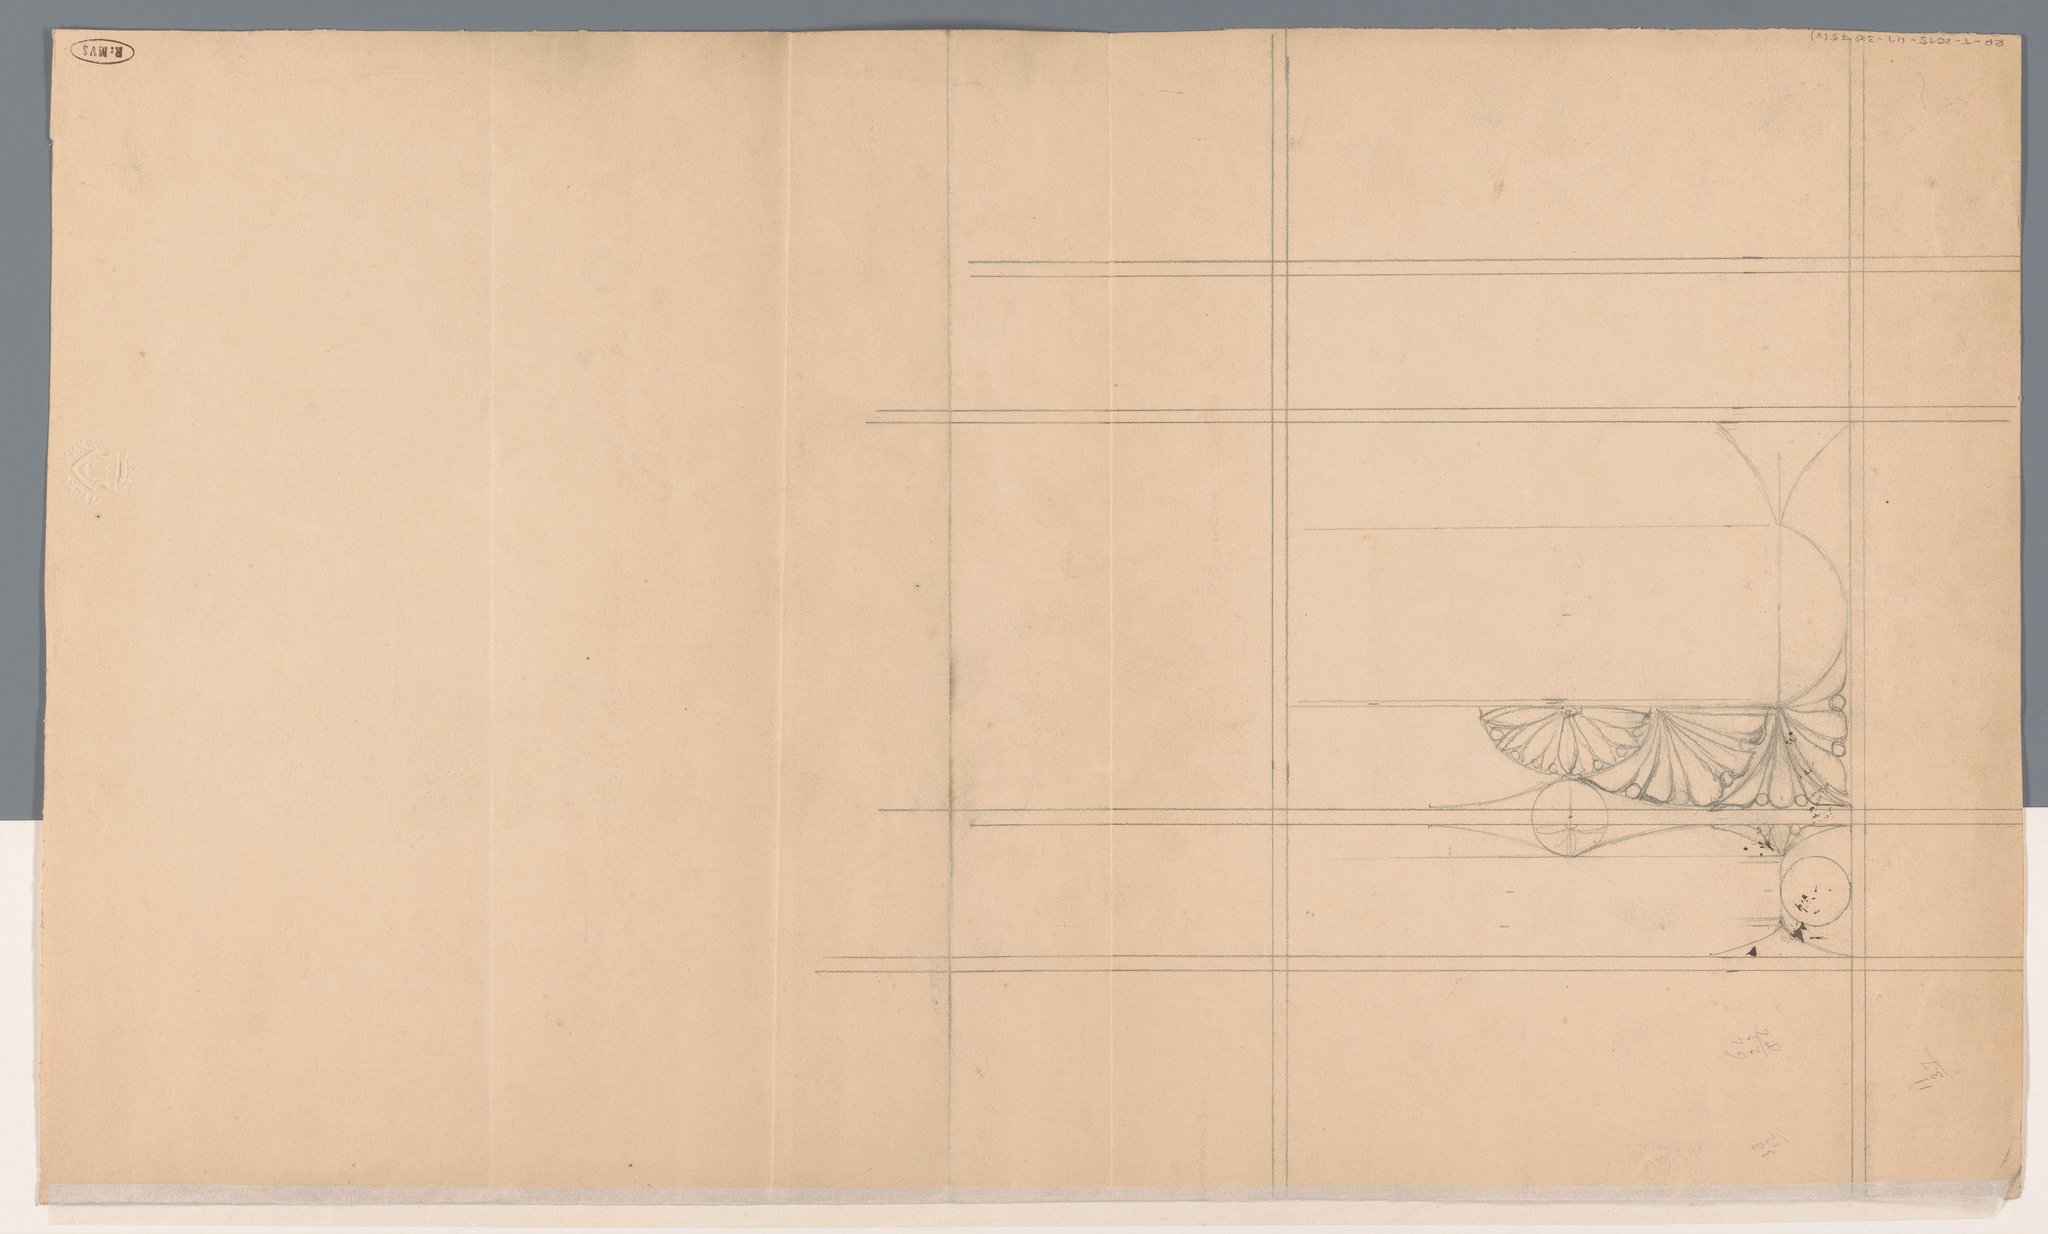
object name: drawing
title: Bandontwerp voor: Max Rooses, De teekeningen der Vlaamsche meesters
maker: johann georg van caspel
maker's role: draughtsman, print maker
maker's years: 1870-1928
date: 1900-1915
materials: paper, pencil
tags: flowers ~ ornament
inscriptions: collector's mark: Lugt 2228a